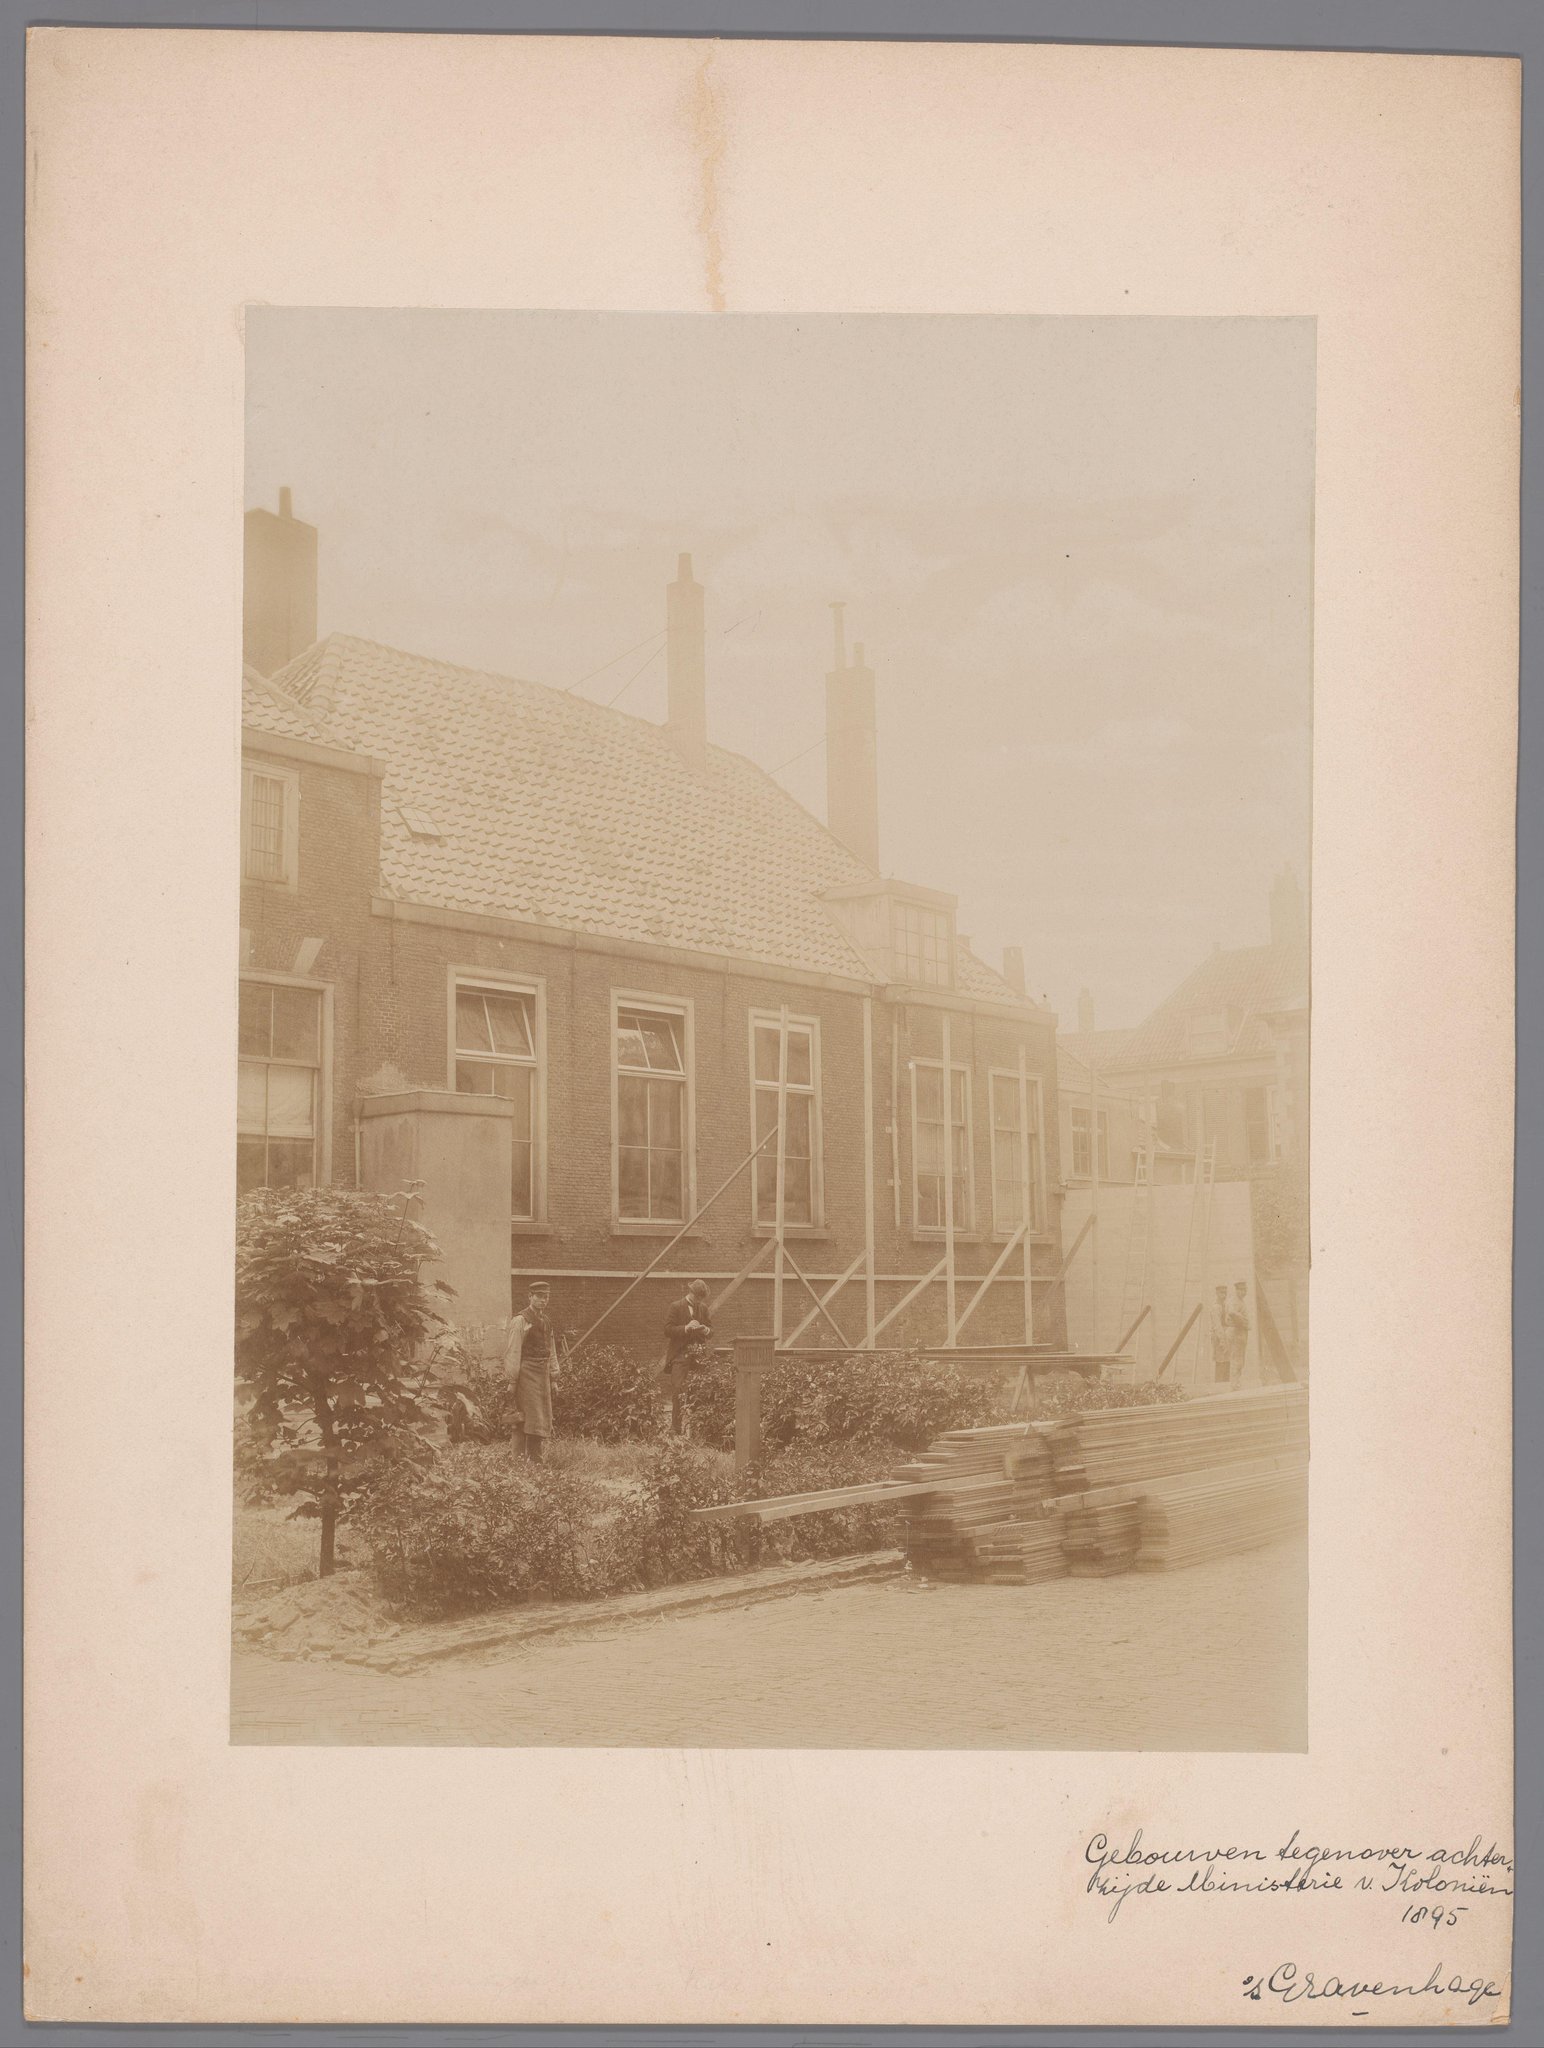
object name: photograph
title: Gebouwen tegenover de achterzijde van het voormalige Ministerie van Koloniën te Den Haag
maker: anoniem (monumentenzorg)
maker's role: fotograaf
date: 1895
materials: cardboard, photographic support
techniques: collodion silver print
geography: the hague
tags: urban housing, public road (+ city(-scape) with figures, staffage), the hague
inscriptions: annotation: ‘'s Gravenhage (Z.H.)/ gebouwen tegenover de achterzijde v/h Ministerie van Kolonieën/ Juni 1895’, annotation: ‘Gebouwen tegenover achterzijde Ministerie v. Kolonieën/ 1895/ 's Gravenhage’, collector's mark: ‘R:MUS.’ Lugt 2228